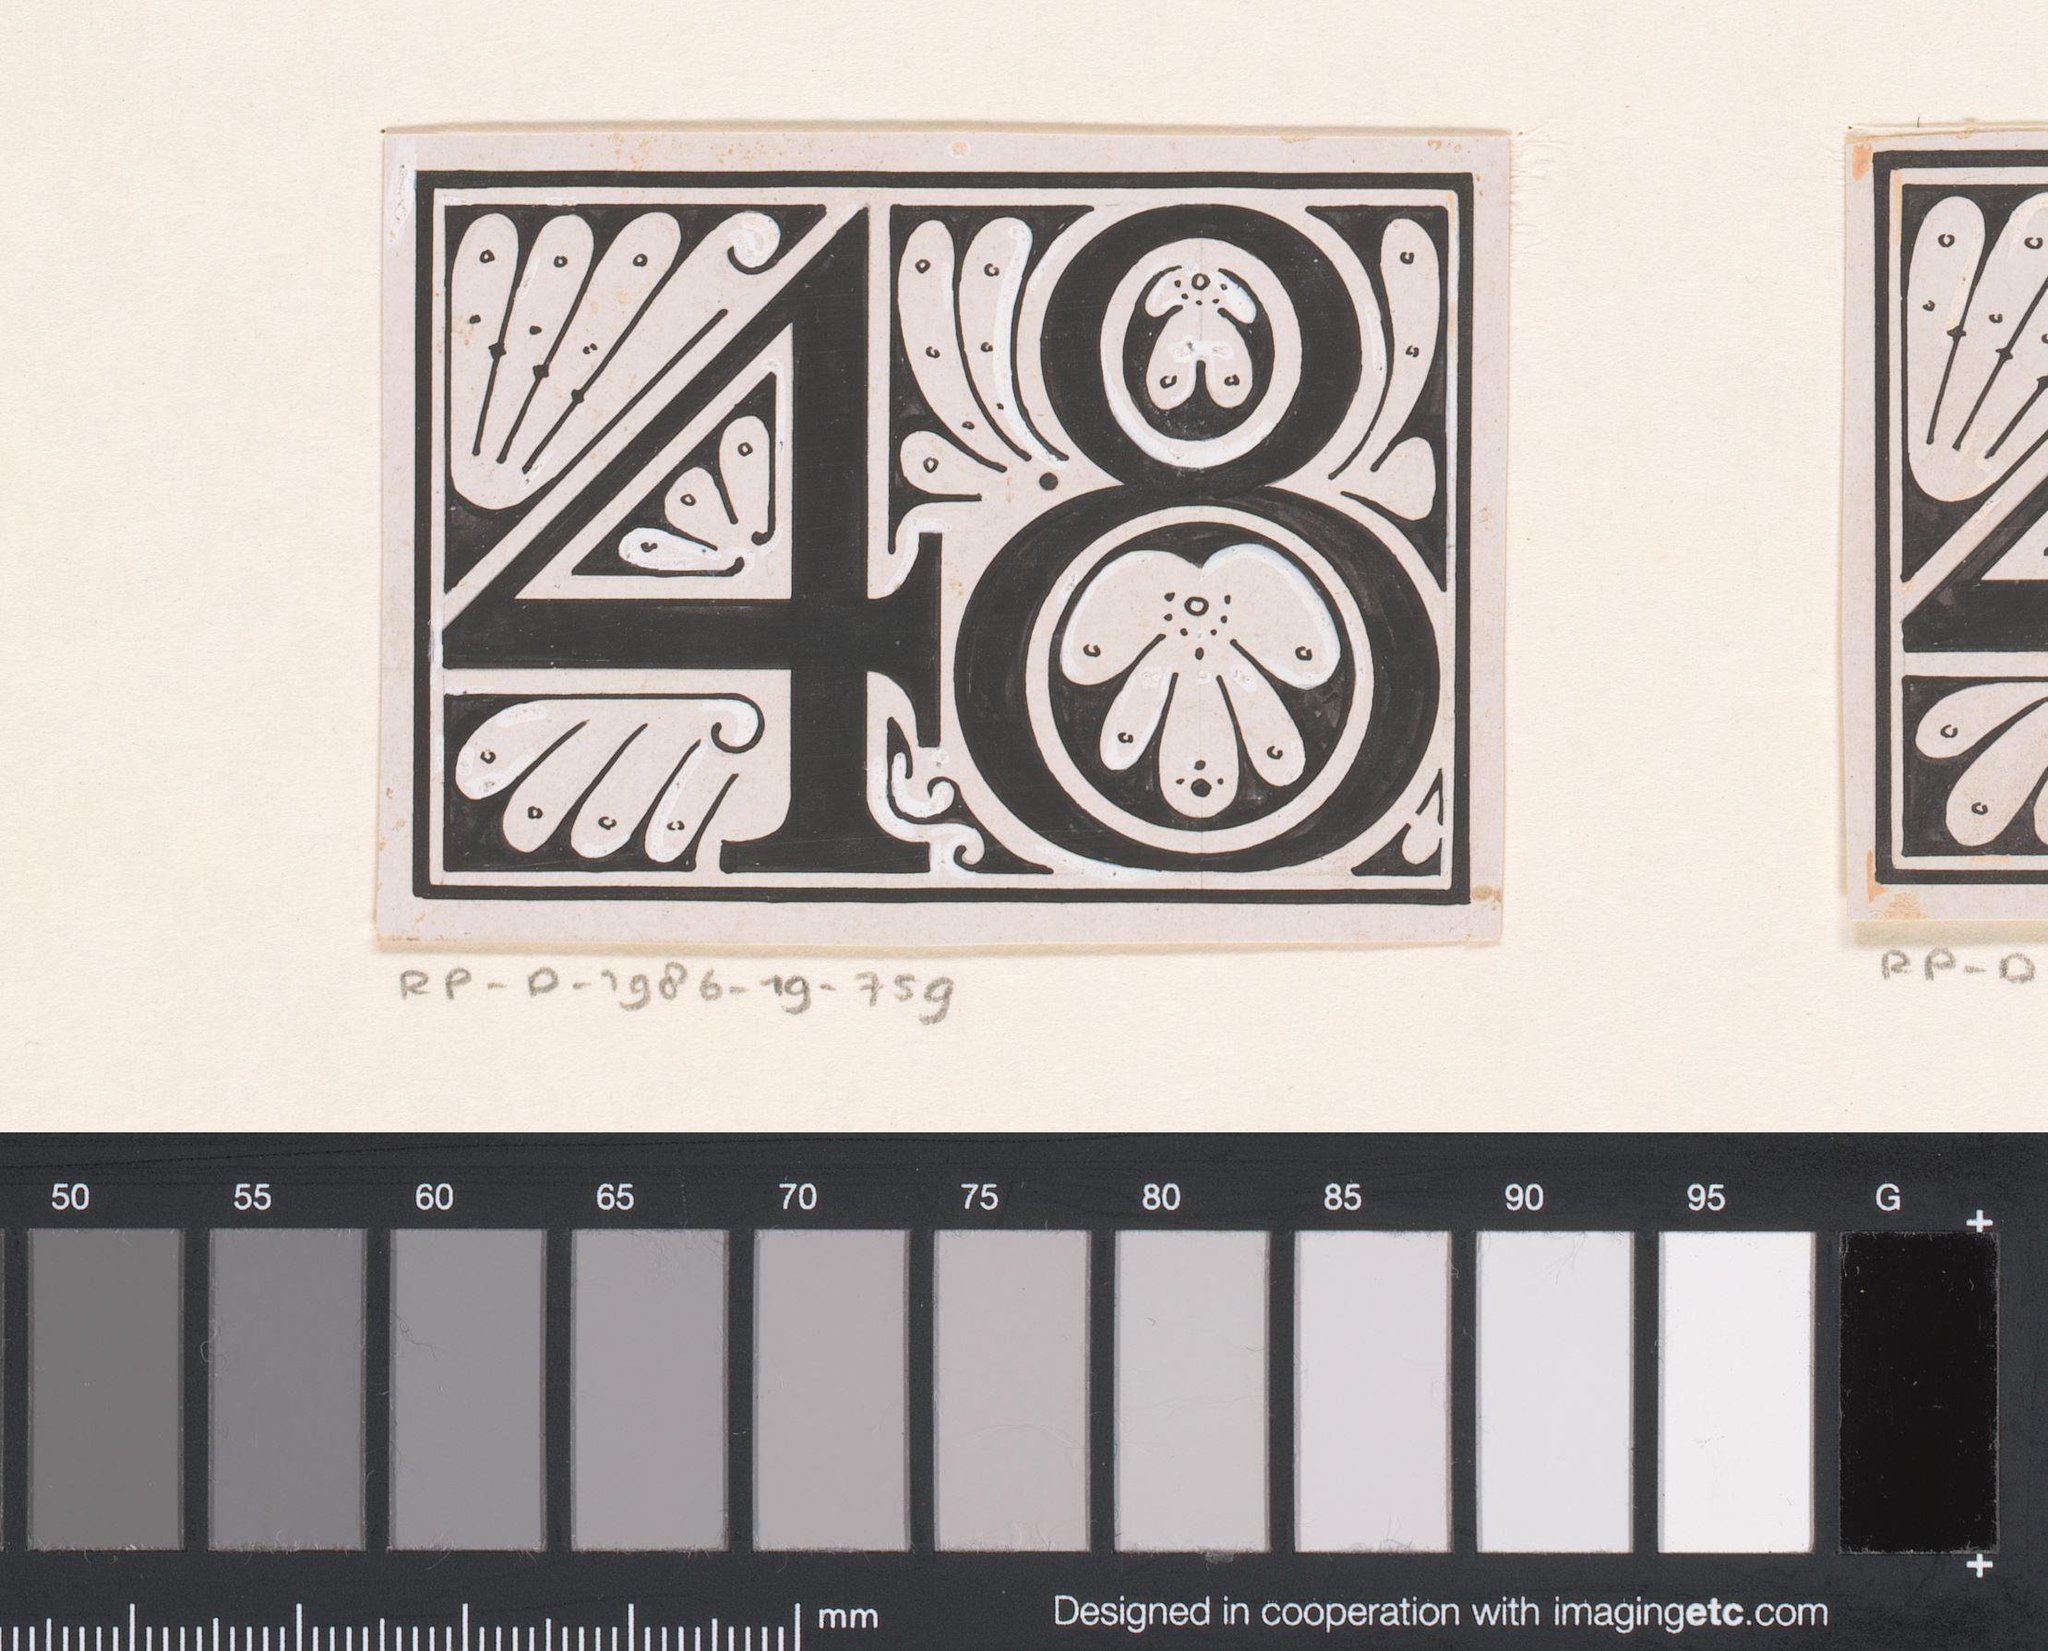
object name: design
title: Getal 48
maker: reinier willem petrus de vries (1874-1953)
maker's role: draughtsman, print maker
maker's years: 1874-1953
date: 1904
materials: paint, ink, paper, pencil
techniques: brush, pen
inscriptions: collector's mark: ‘R:MVS.’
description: Het getal is gebruikt voor: Veth, Jan. Jozef Israëls en zijn kunst. Arnhem en Nijmegen: Gebroeders E&M Cohen, 1904.